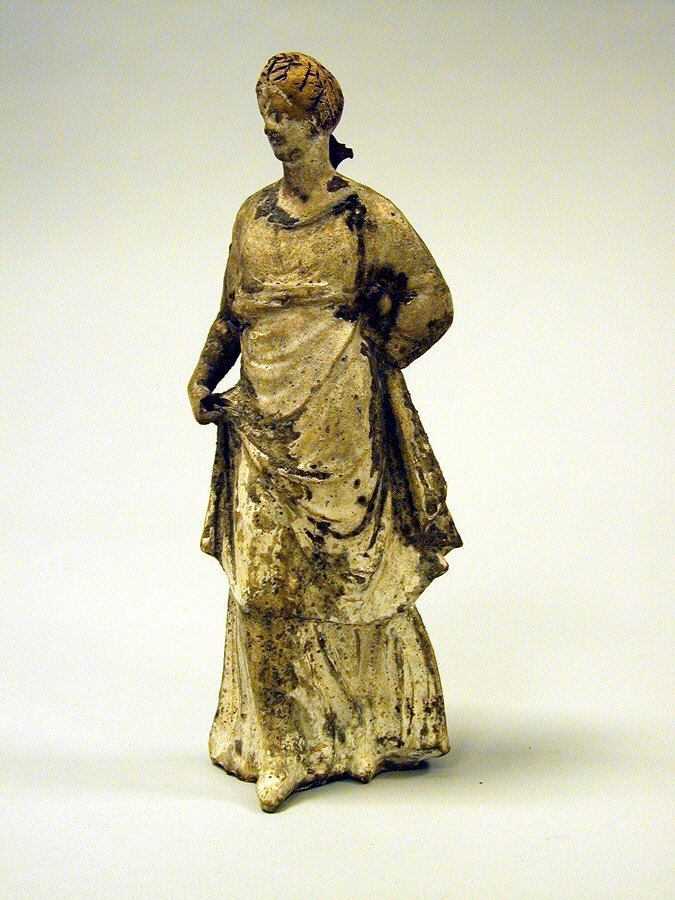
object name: statuette of a woman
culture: greek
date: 300-201 BCE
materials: terracotta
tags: women